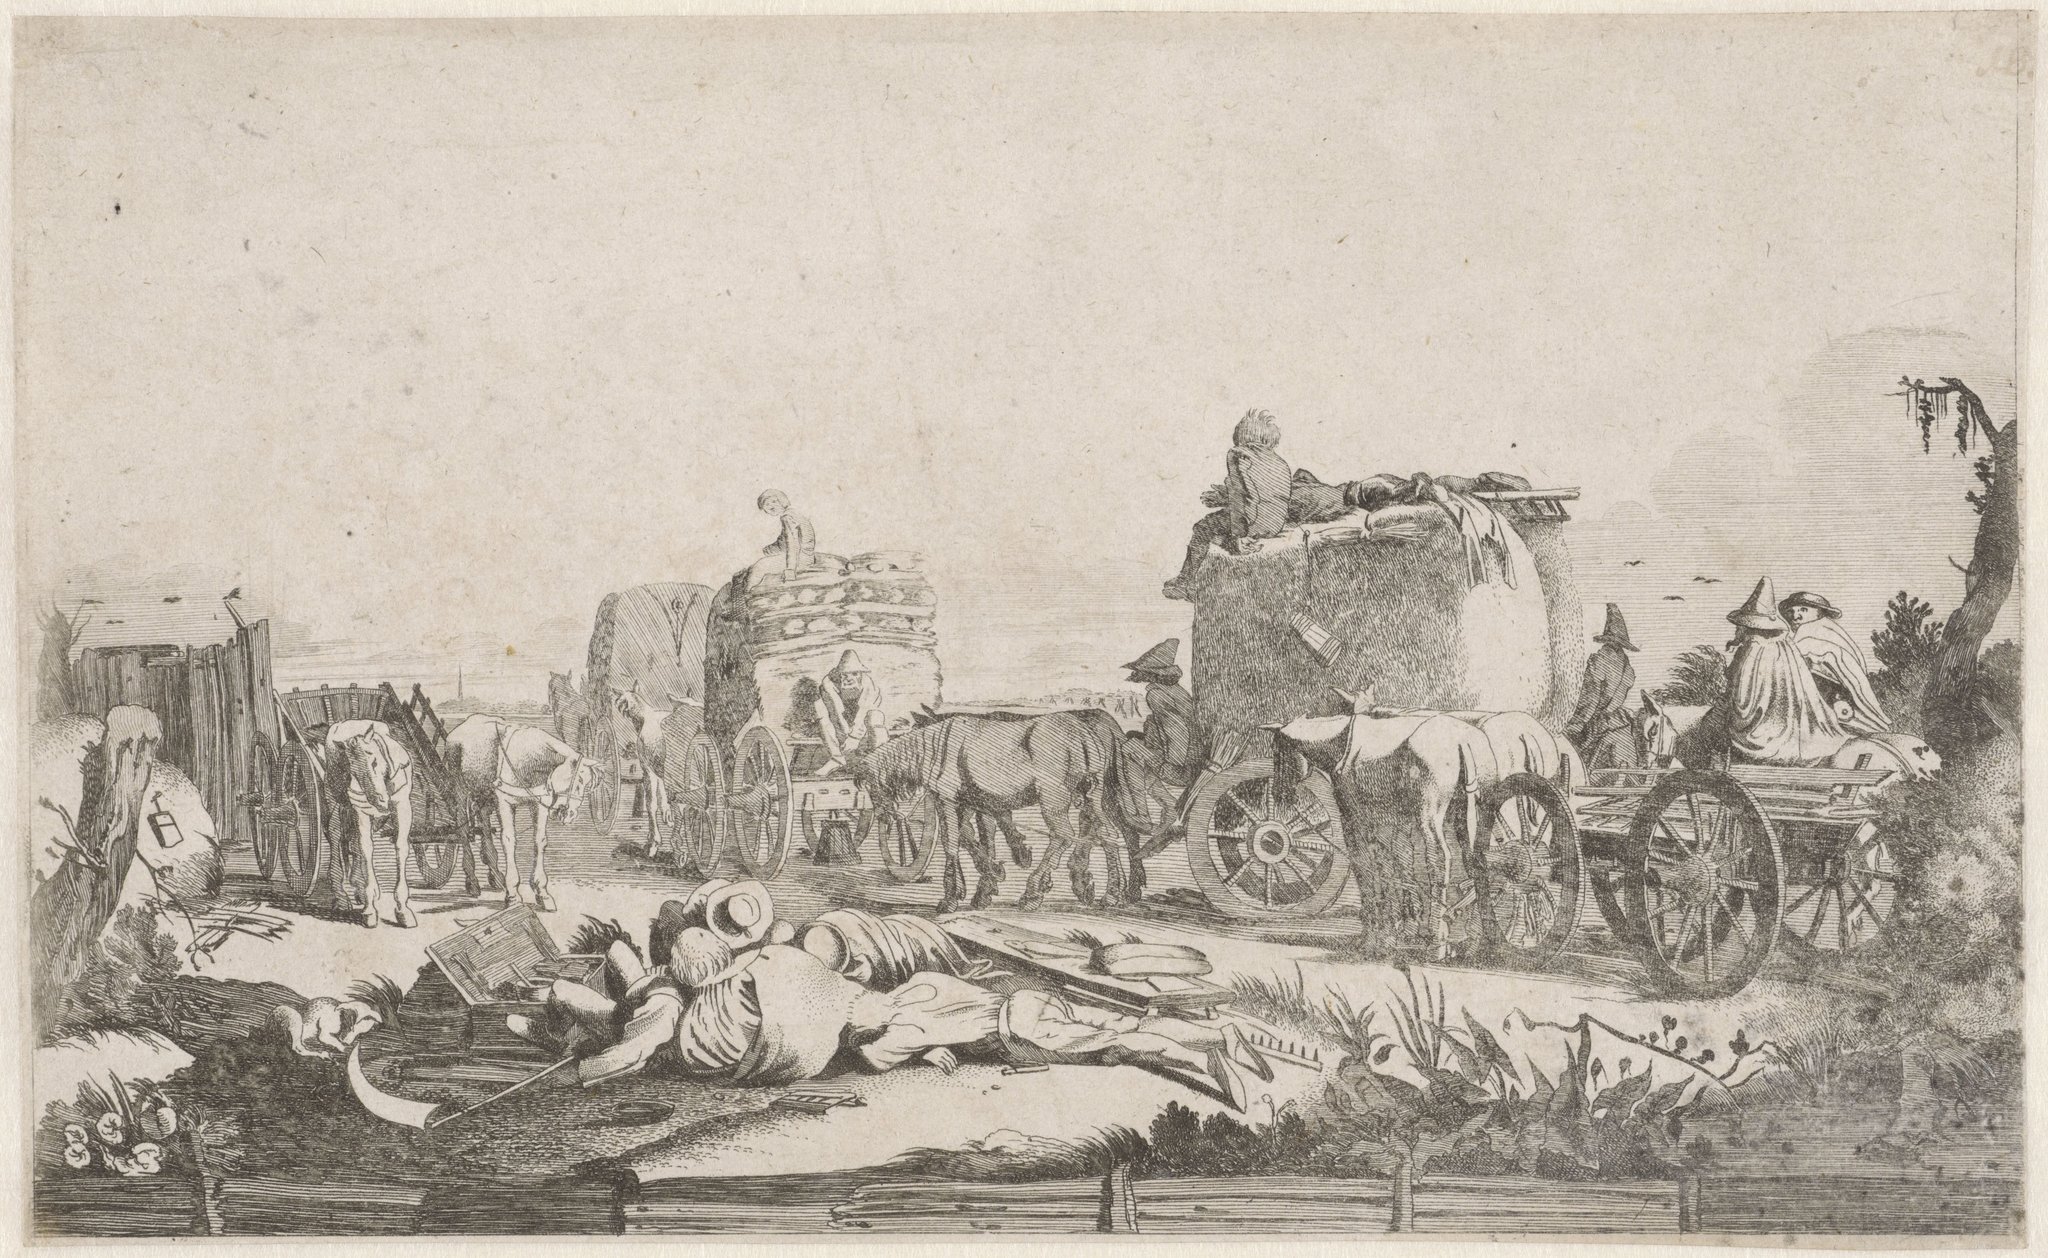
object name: print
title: Zomer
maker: gillis van scheyndel (i)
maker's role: draughtsman, print maker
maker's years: 1595-1660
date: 1622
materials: paper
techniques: engraving, etching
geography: netherlands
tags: summer ~ human activities (the four seasons of the year), transporting ~ harvest, rest during harvest (eating, dancing, making love, etc.)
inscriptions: collector's mark: Lugt 2228, collector's mark: Lugt 2760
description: Zomerlandschap met de hooioogst. Een stoet hoog opgetaste hooiwagens wordt gevolgd door drie mannen te paard. Op de voorgrond rusten landarbeiders, naast een open provisiekist en een hond. Twee hooiladers met paard, een links en een rechts, staan klaar voor een nieuwe vracht.